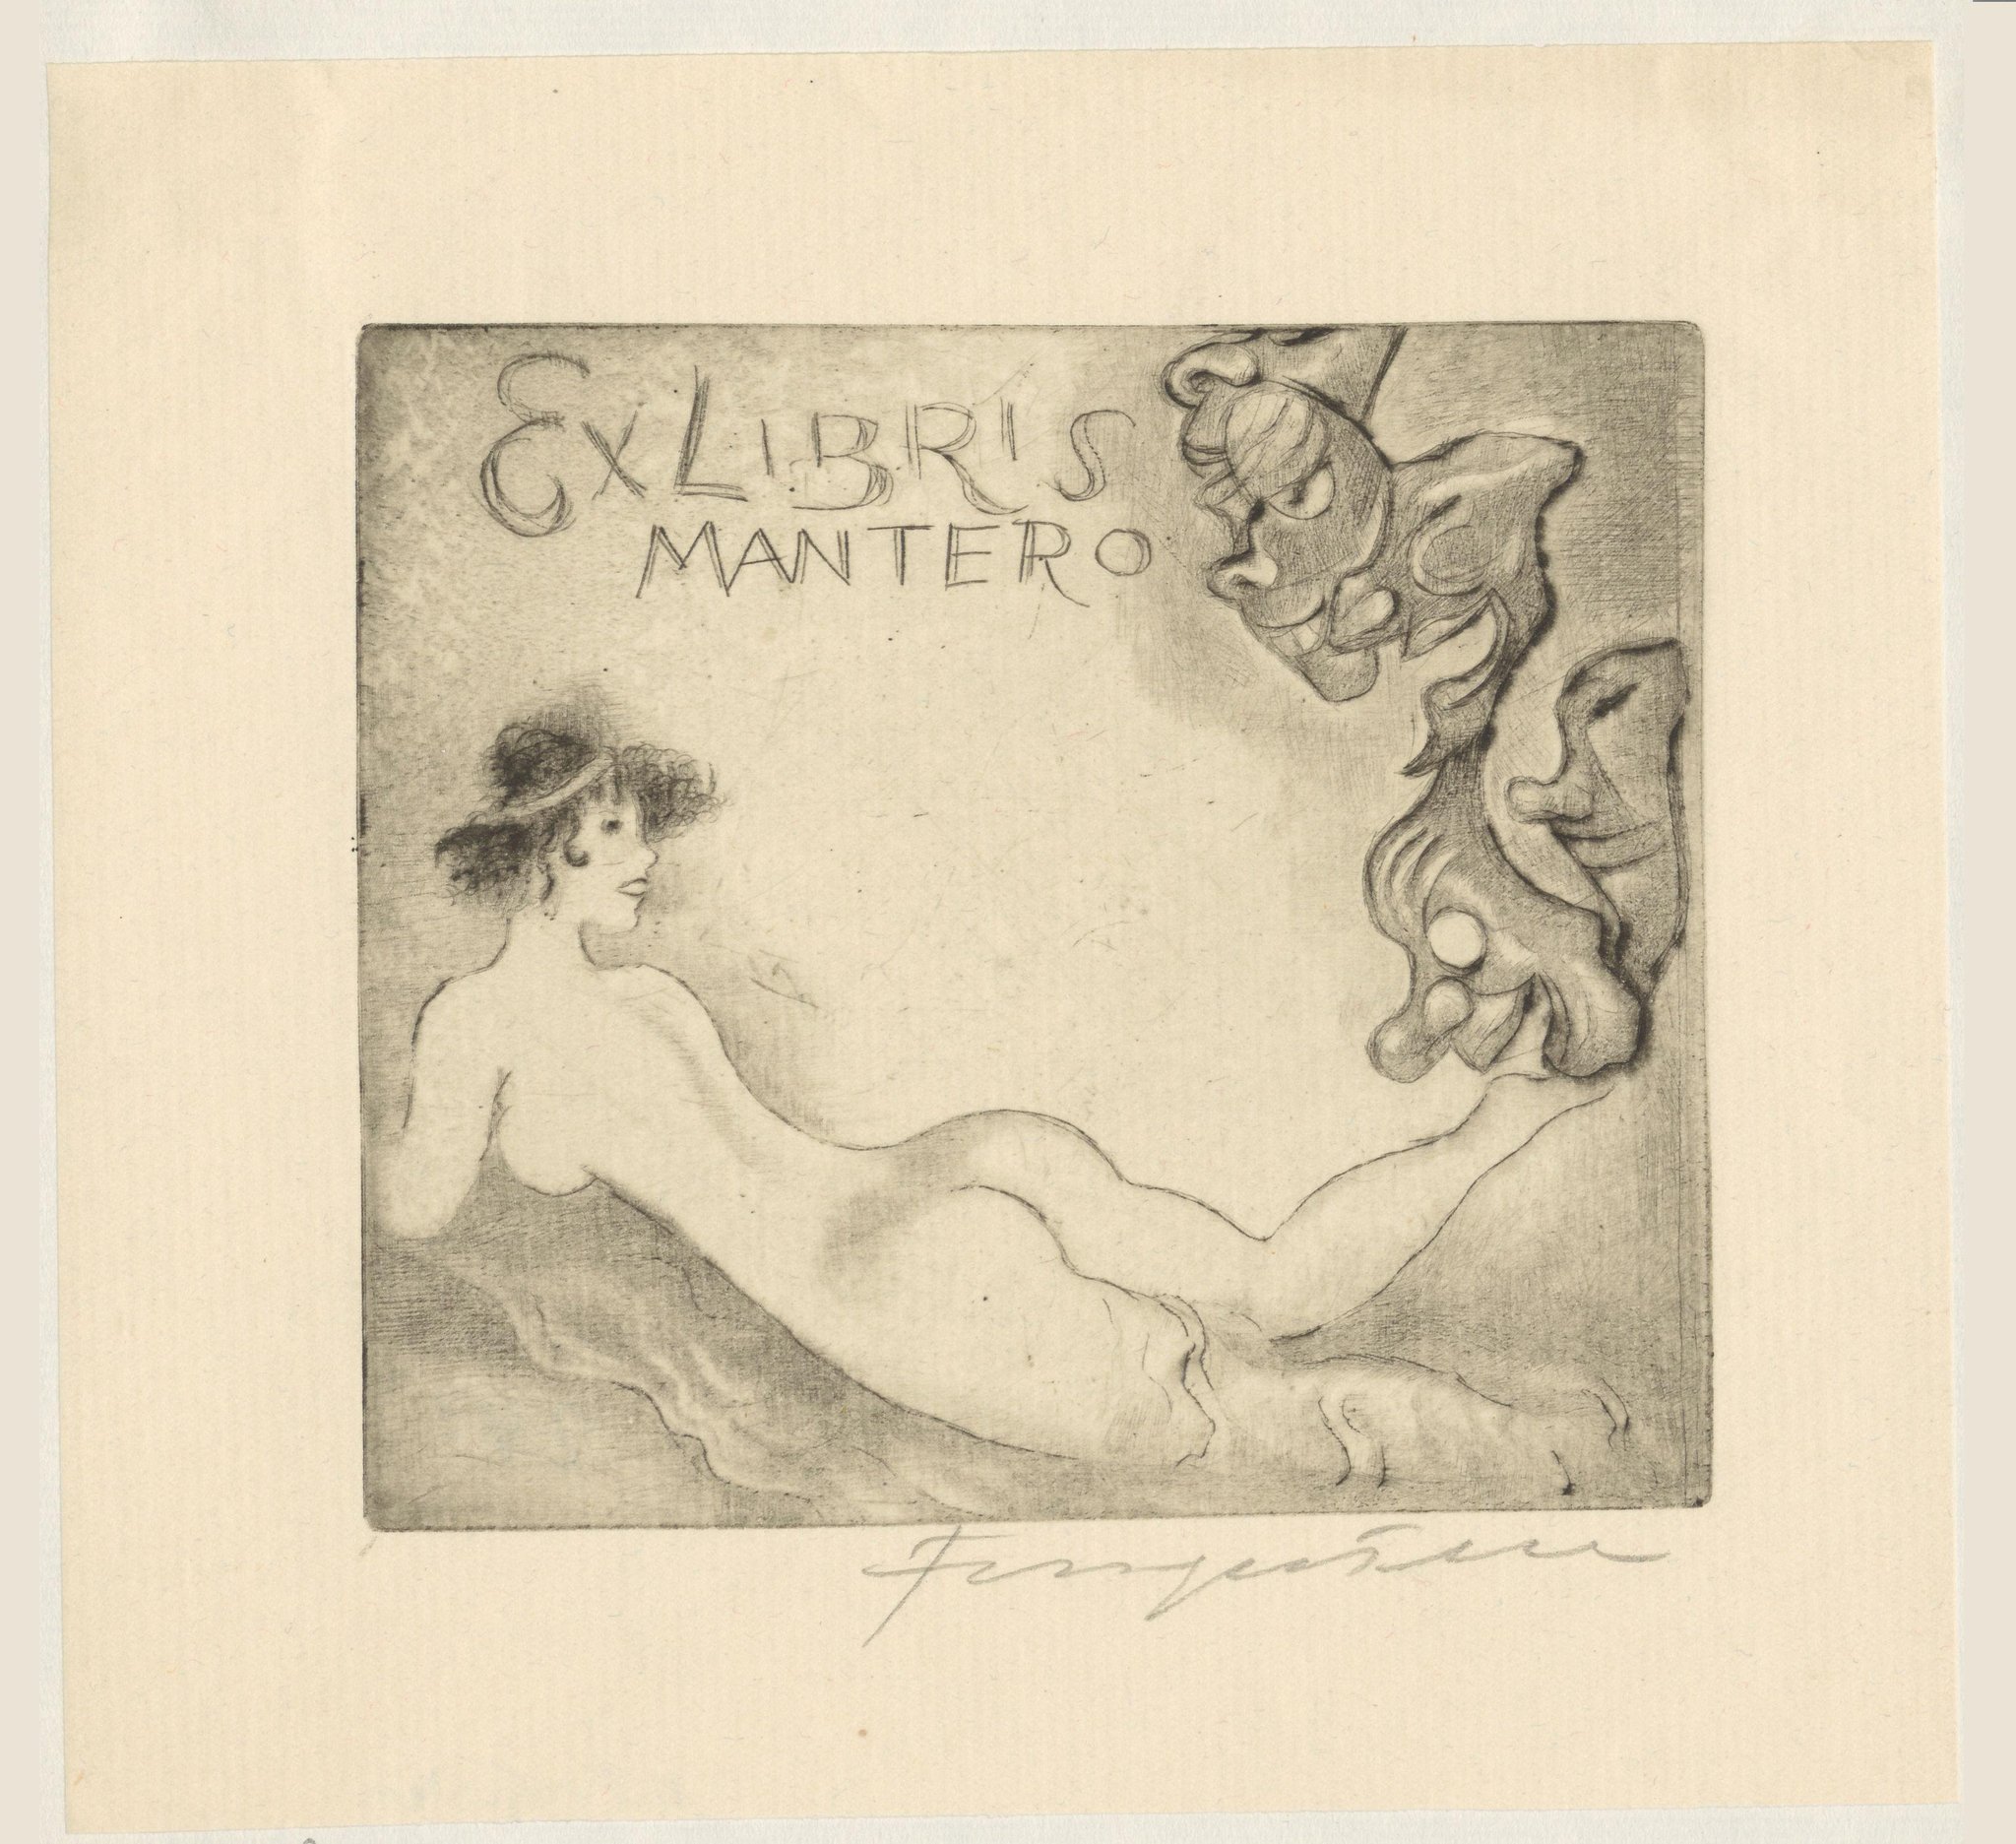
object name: bookplate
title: Ex libris van Mantero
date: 1930-1943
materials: paper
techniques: photograph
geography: milan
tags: gianni mantero, mask, woman (showing herself) undressed, quasi-nude, lying figure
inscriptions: signature: ‘Fingesten’